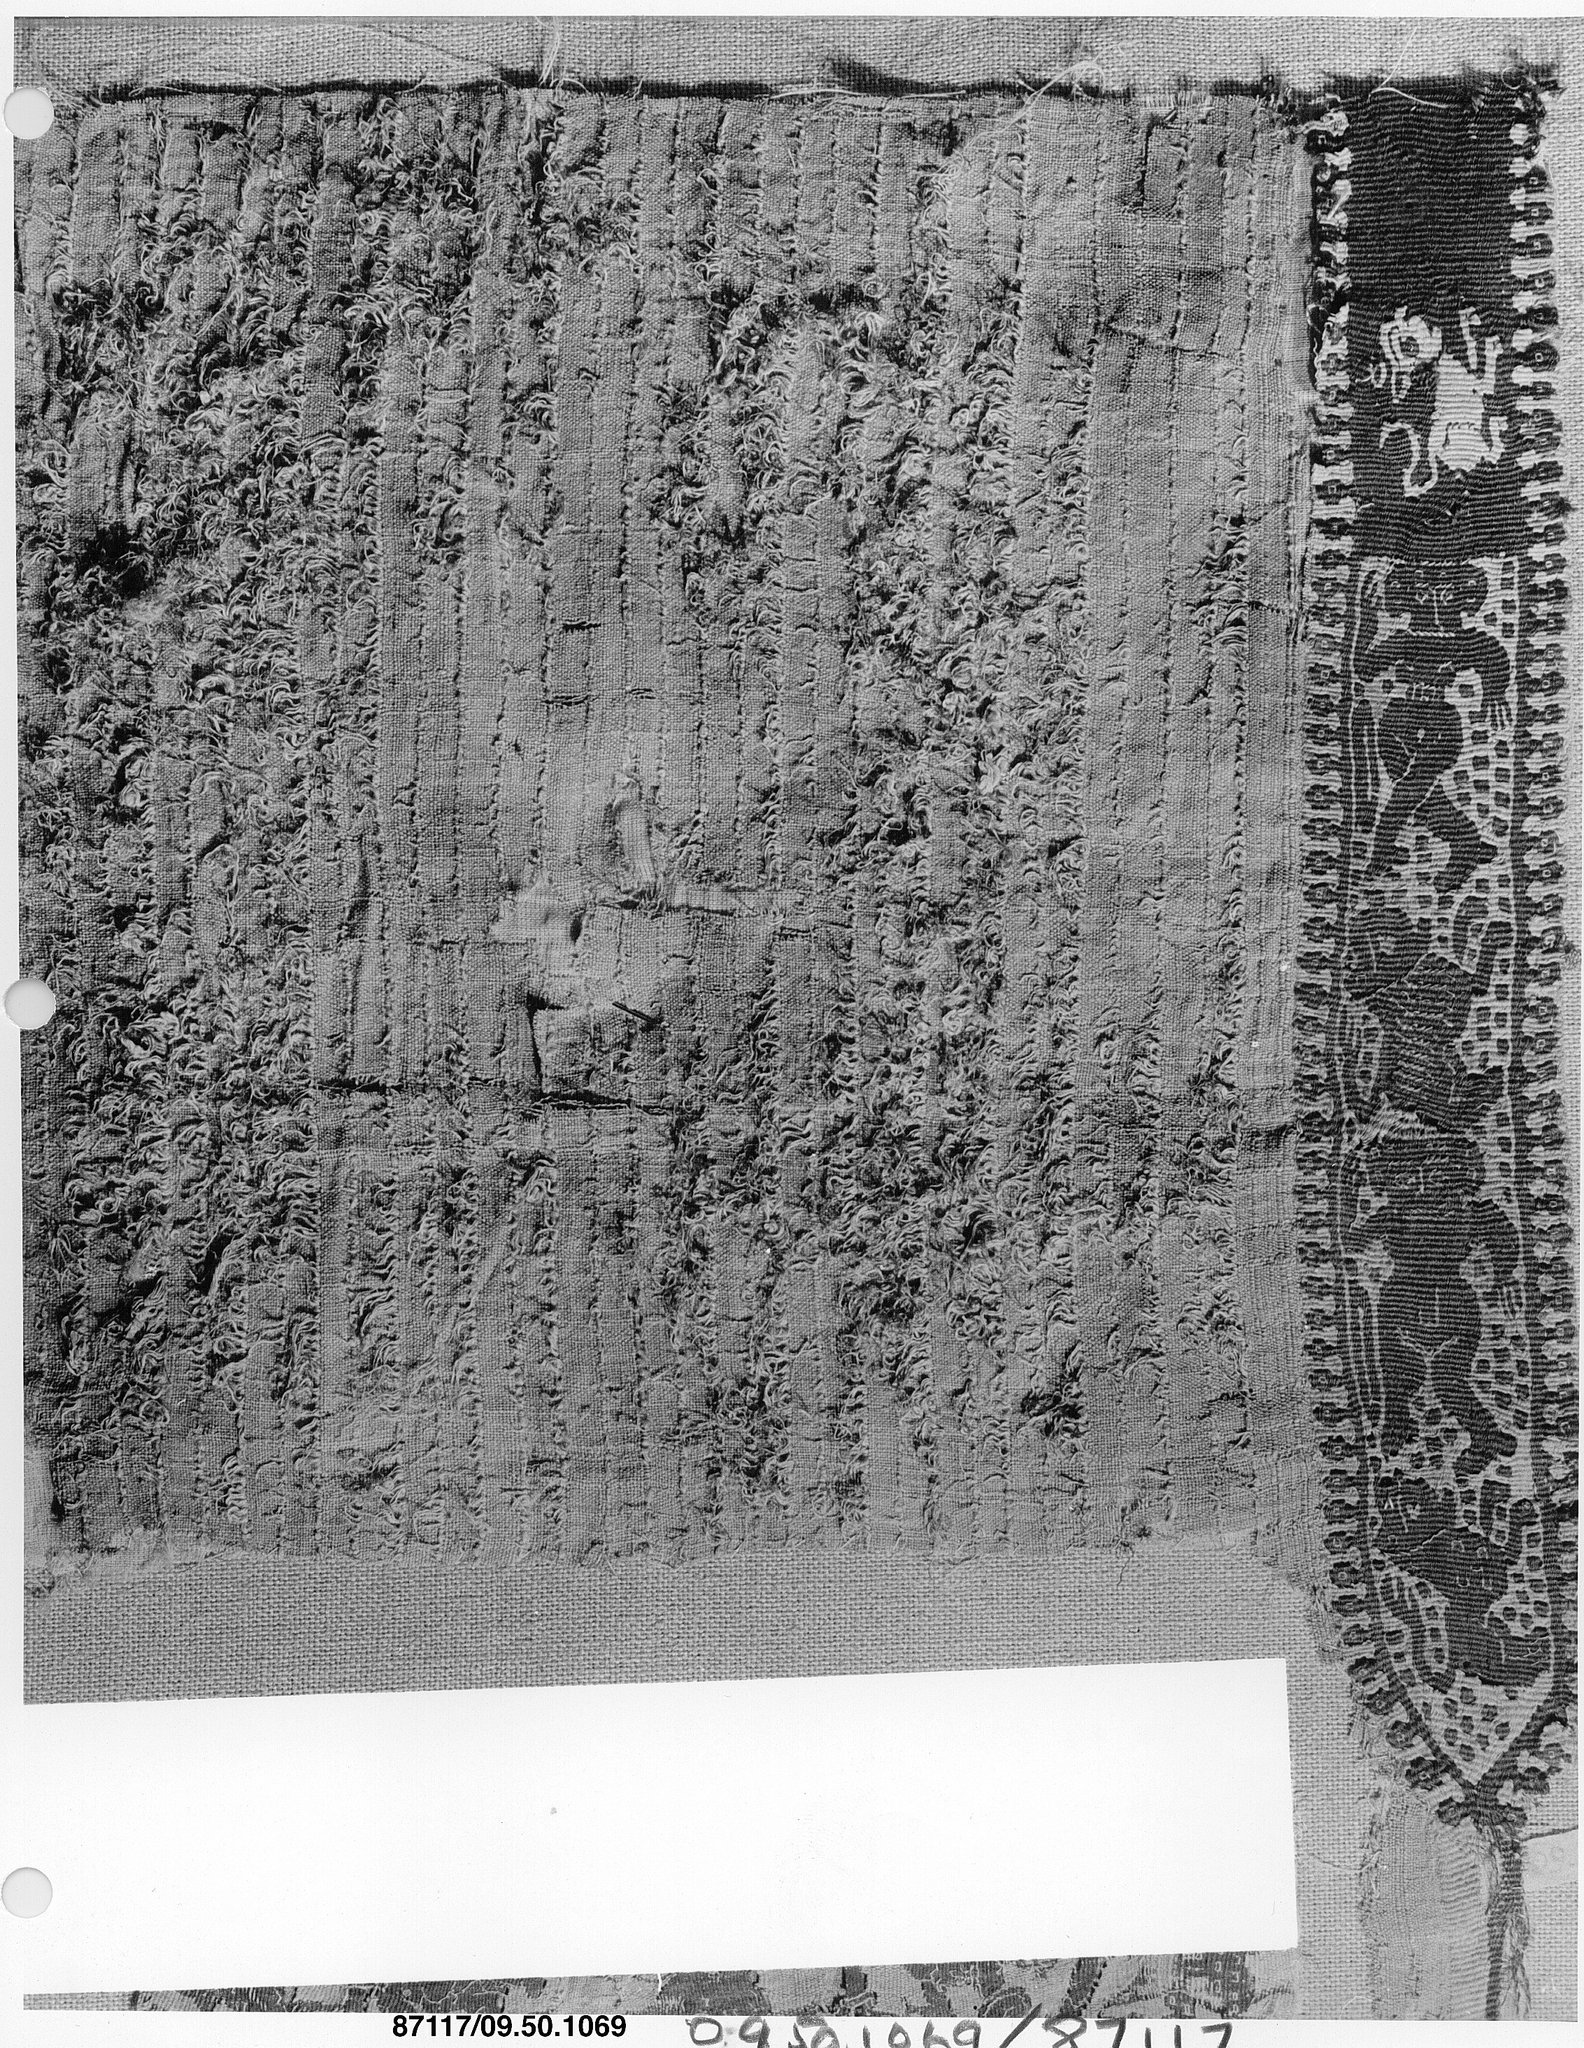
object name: tunic fragment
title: Fragment of a Tunic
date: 301-500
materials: linen, wool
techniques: weave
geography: egypt